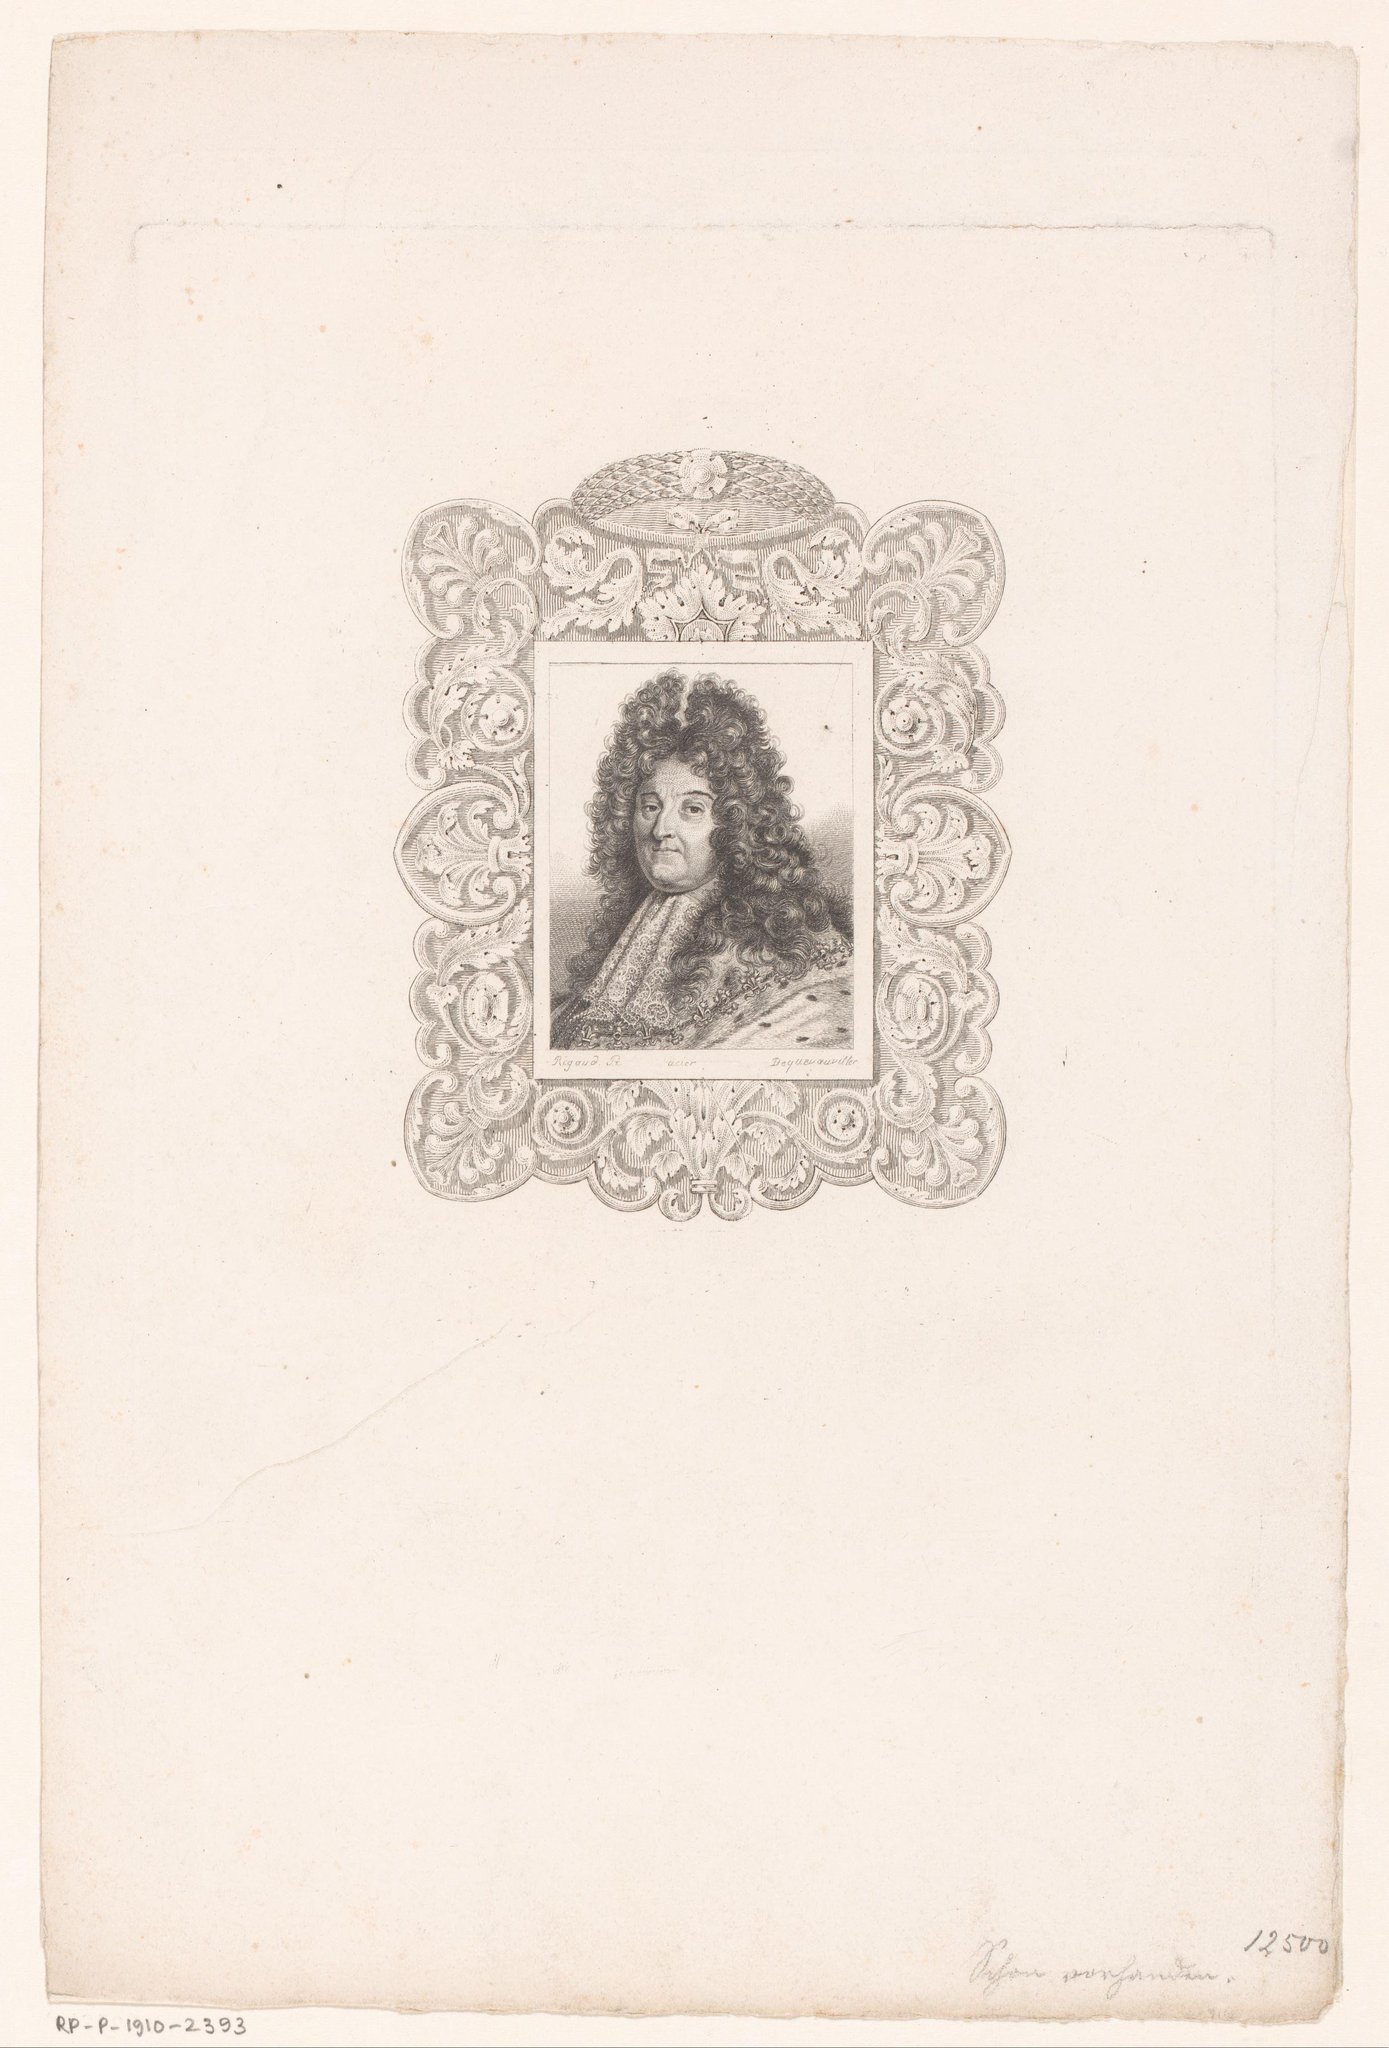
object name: print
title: Portret van Lodewijk XIV in een lijst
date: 1793-1848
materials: paper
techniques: engraving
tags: lodewijk xiv (koning van frankrijk), historical persons, king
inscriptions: collector's mark: Lugt 2228